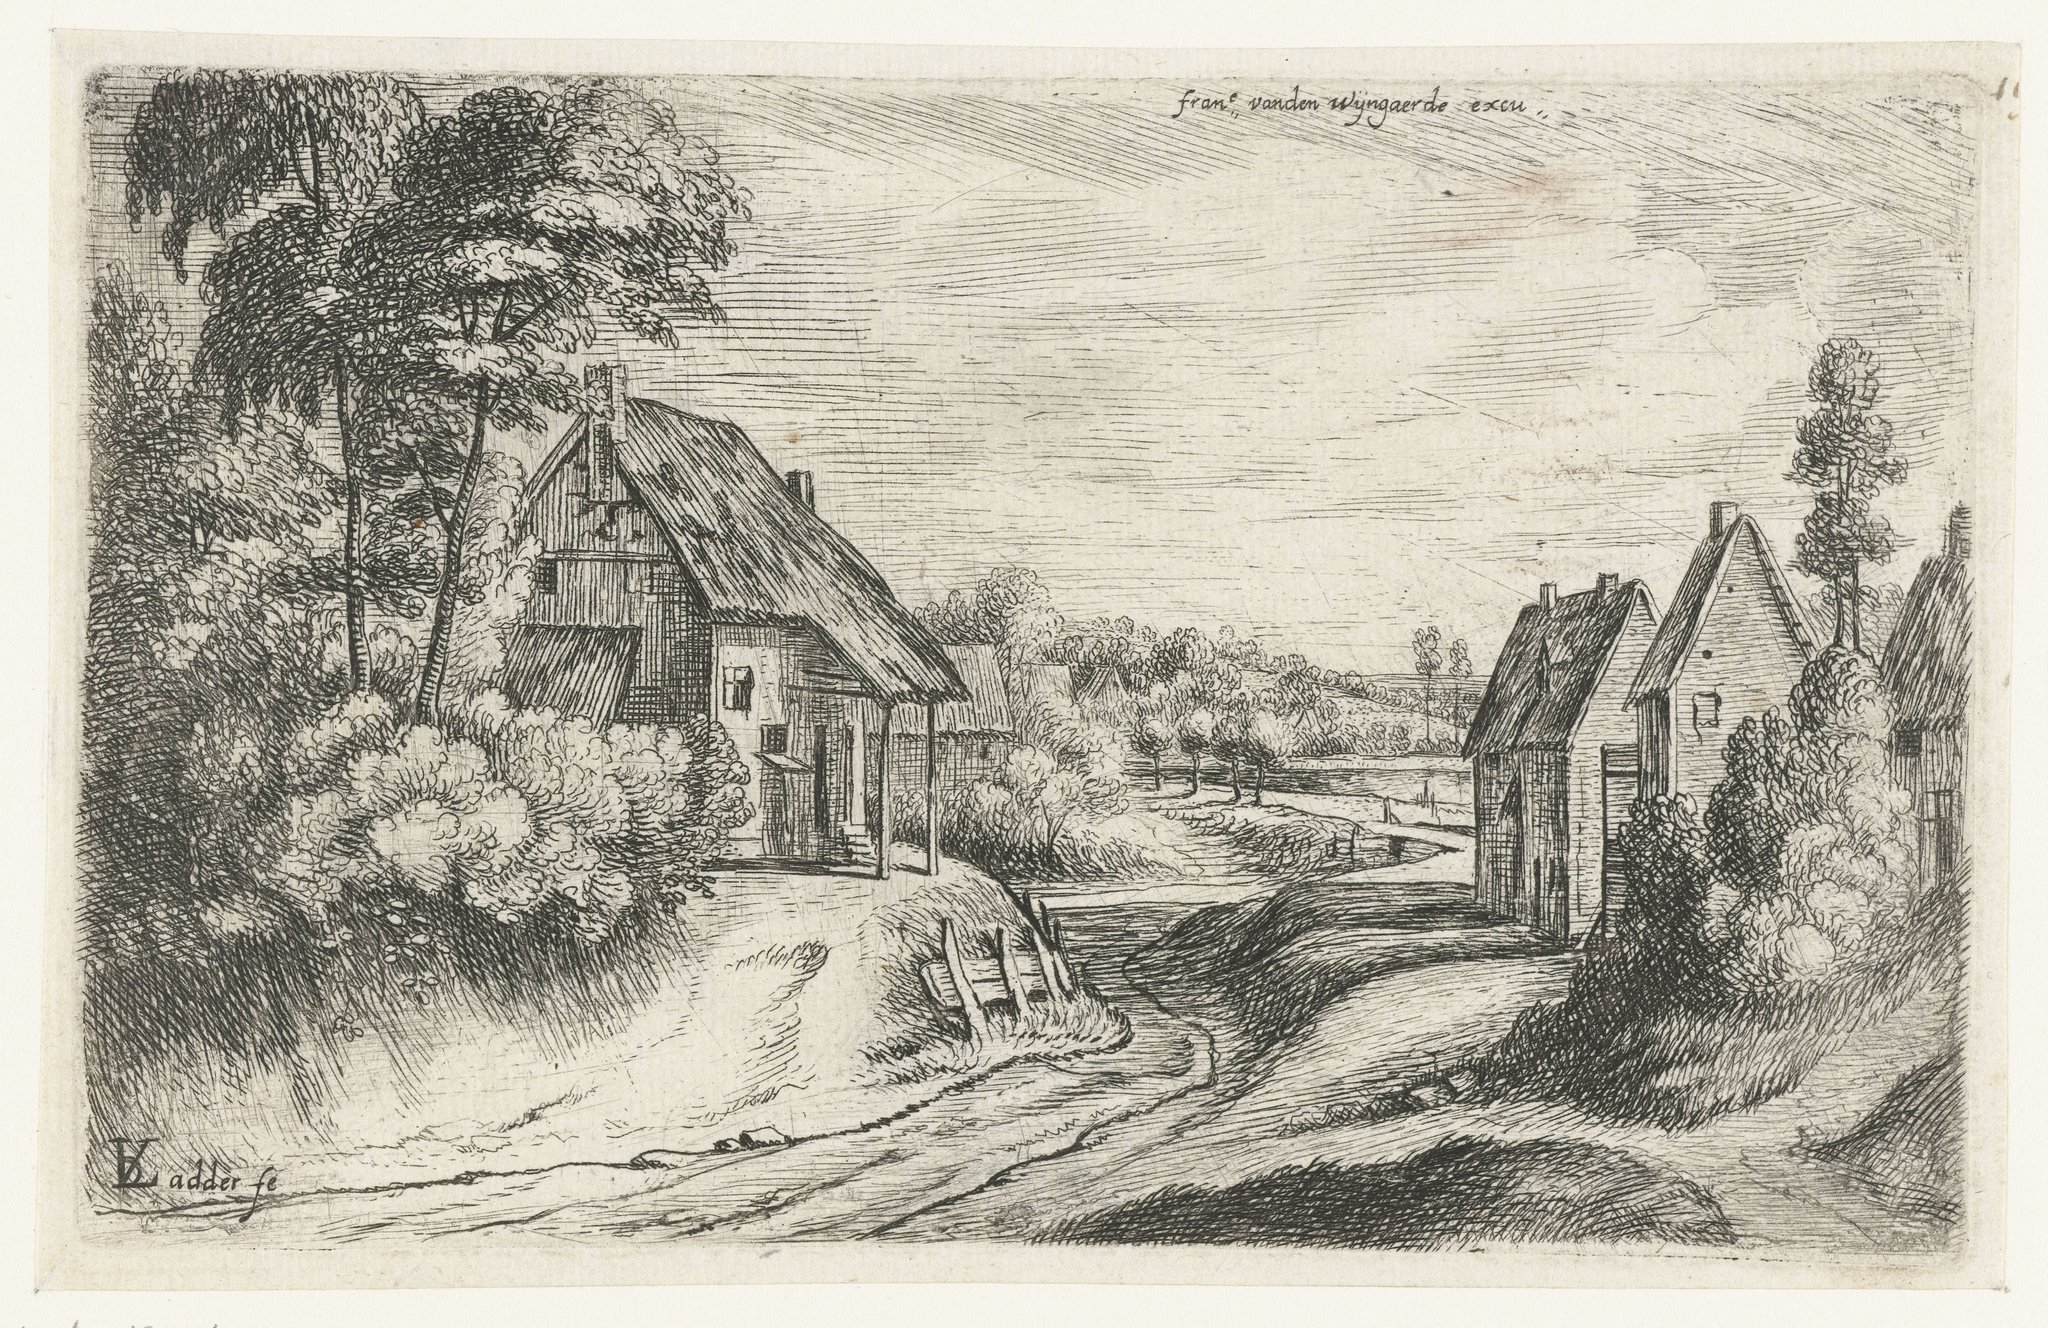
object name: print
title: Landschap met twee boerderijen langs een weg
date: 1615-1655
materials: paper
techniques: engraving, etching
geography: low countries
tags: road, path, farm or solitary house in landscape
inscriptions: collector's mark: Lugt 2228